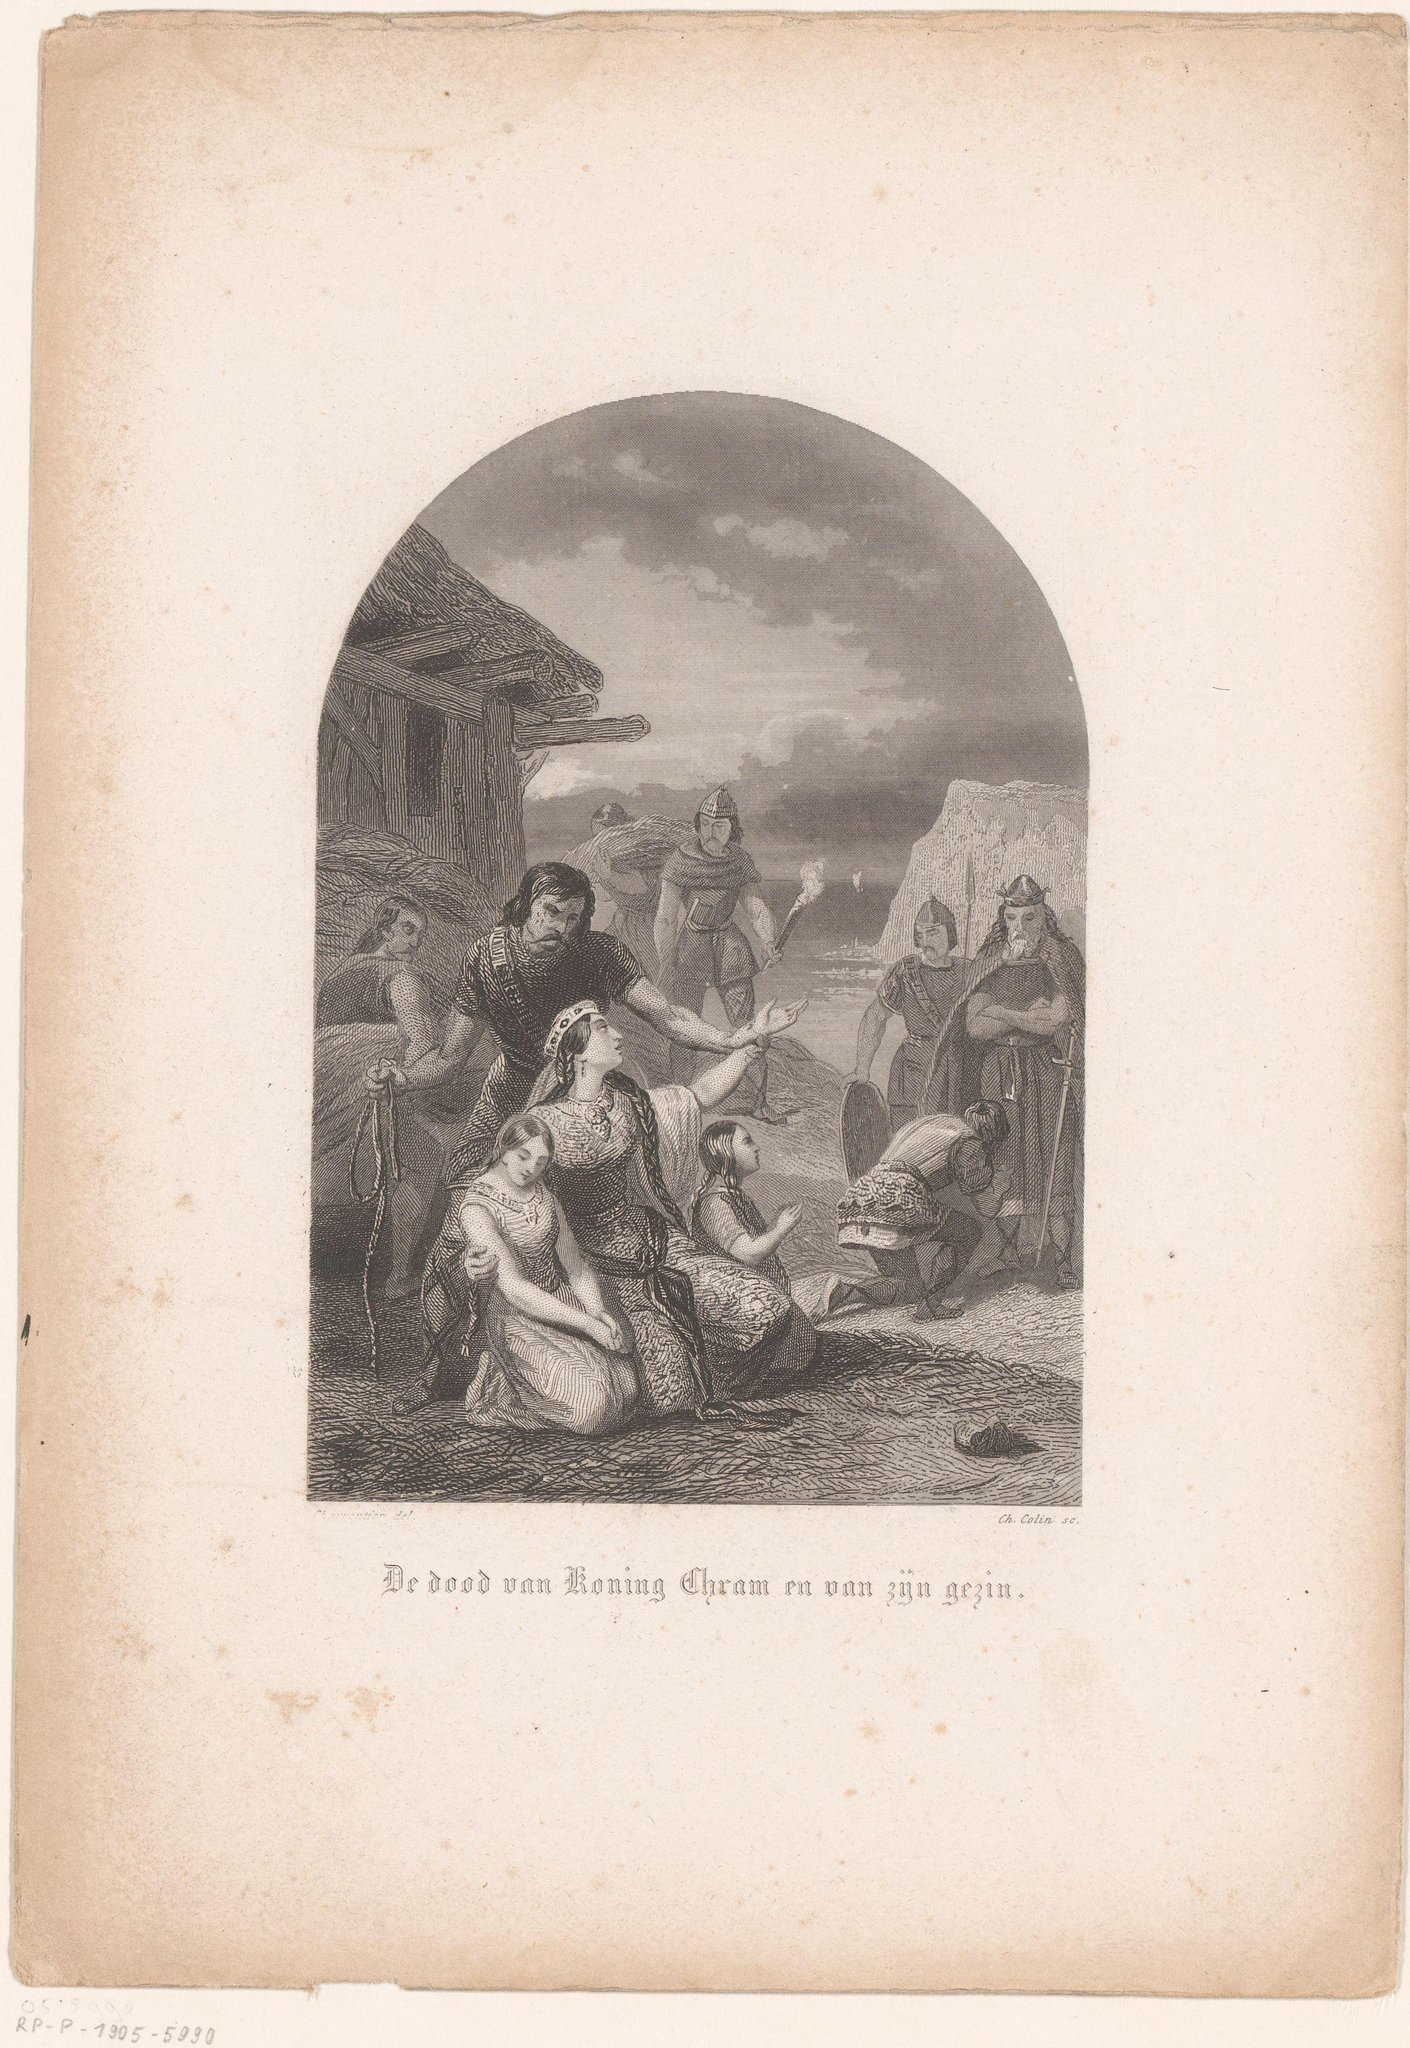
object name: print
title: De dood van koning Ehram en van zijn gezin.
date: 1818-1873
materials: paper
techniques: engraving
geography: france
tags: person under sentence of death hears that he is to be executed, family, relationship, descent, ruler, sovereign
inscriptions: collector's mark: Lugt 2228